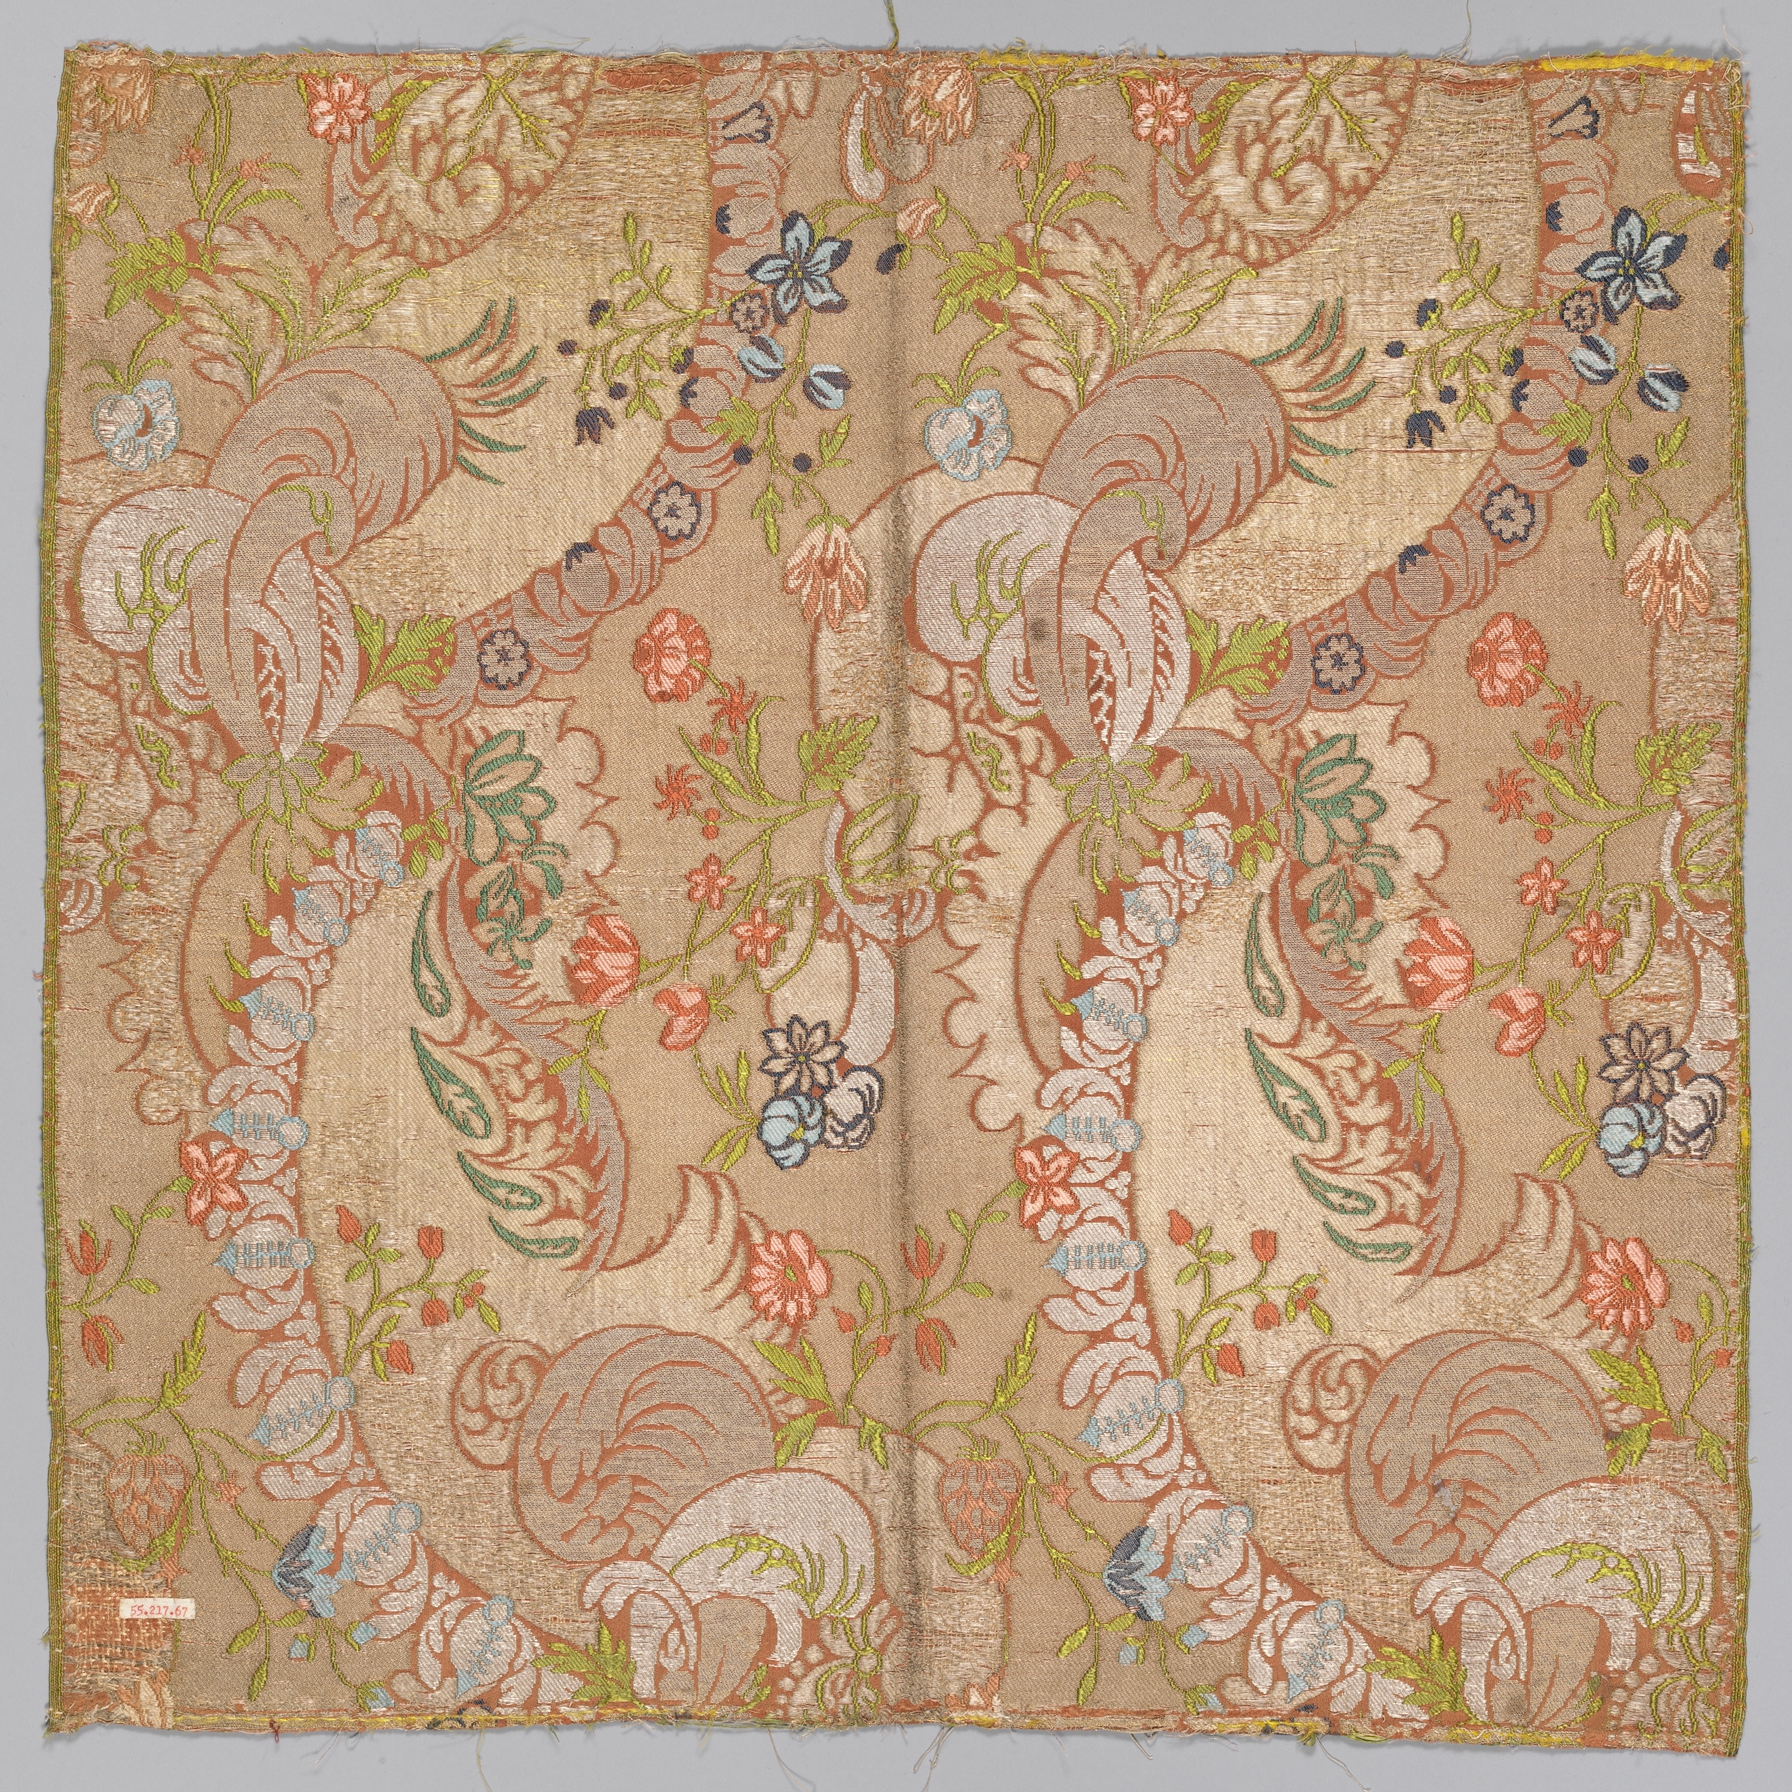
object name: chalice cover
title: Chalice veil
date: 1720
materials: metal thread, silk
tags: flowers